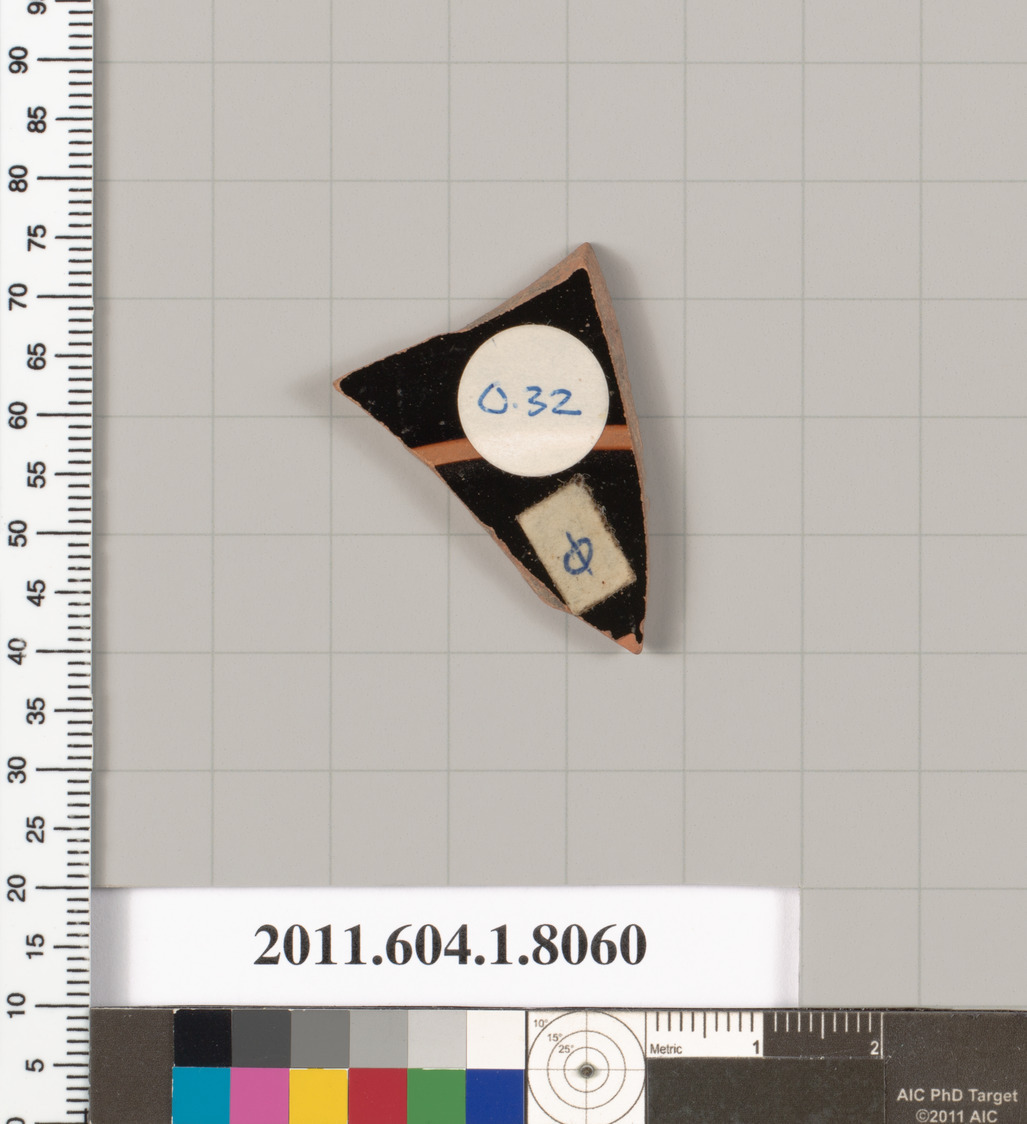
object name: kylix fragment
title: Terracotta fragment of a kylix (drinking cup)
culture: greek, attic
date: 510-500 BCE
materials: terracotta